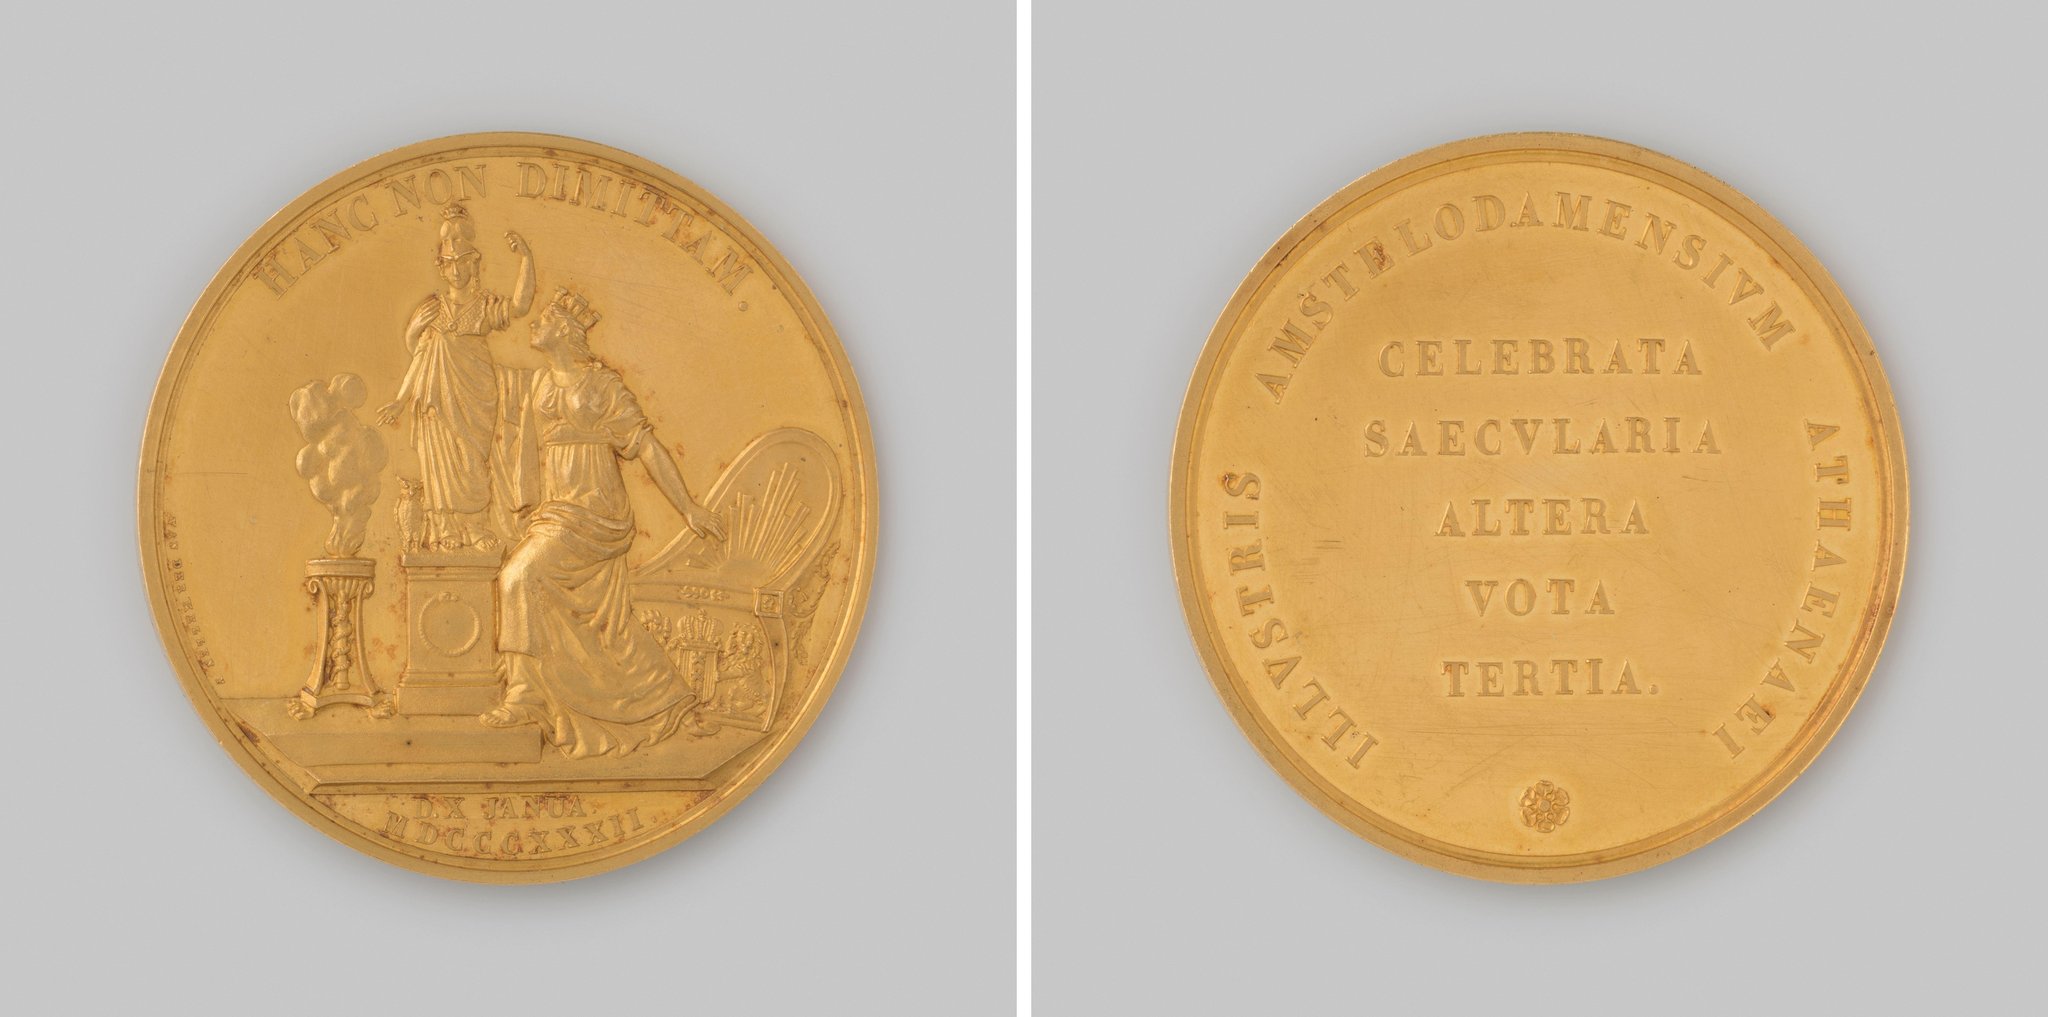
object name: history medal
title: Tweehonderdjarig bestaan van het Athenaeum te Amsterdam 1832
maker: david van der kellen (1804-1879)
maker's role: die cutter, draughtsman, print maker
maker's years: 1804-1879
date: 1832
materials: gold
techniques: striking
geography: utrecht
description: Gouden penning, op de voorzijde de Amsterdamse stadsgodin, opgestaan uit haar zetel, omhelst een standbeeld van Minerva, staand op een zuil waarop een slangenrond afgebeeld, waarnaast een brandende driepoot, met omschrift en afsnedetekst, op de keerzijde vijf regels tekst met omschrift.